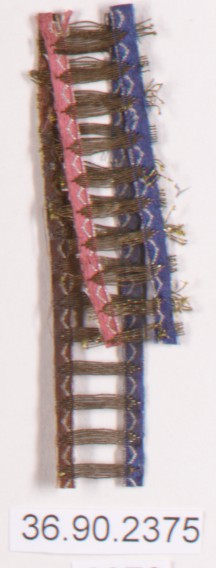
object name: ribbon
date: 1801-1900